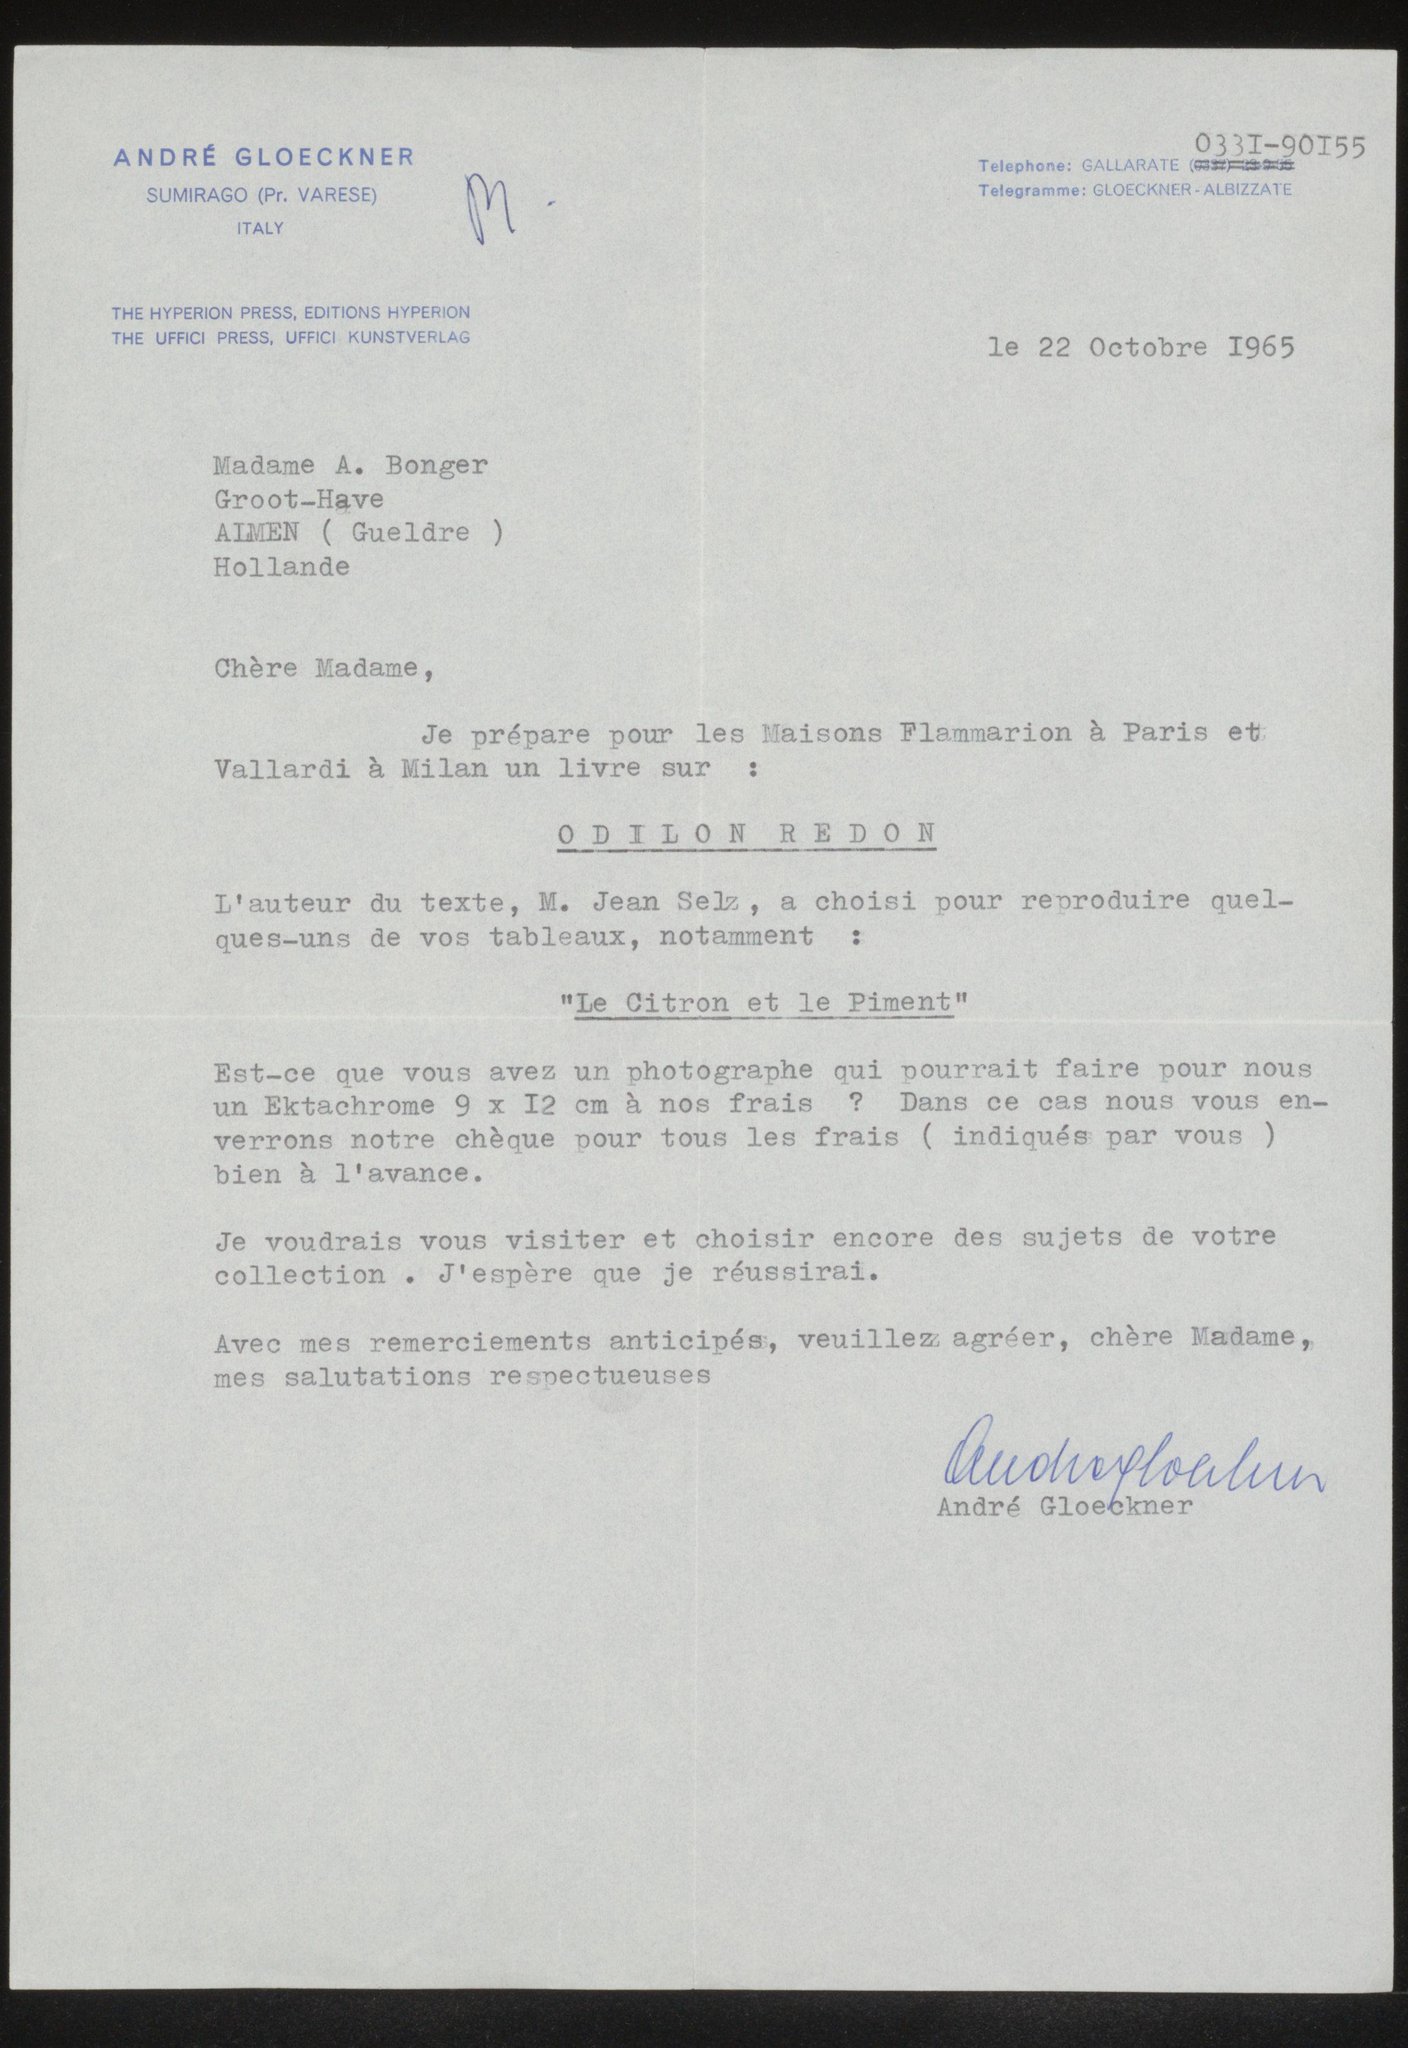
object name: letter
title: Brief aan Françoise W.M. Bonger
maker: andré gloeckner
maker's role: auteur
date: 1965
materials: ink, paper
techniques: pen, typewriting, writing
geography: sumirago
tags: jean selz, paris, painter, print maker, draughtsman, odilon redon, françoise w.m. bonger, photography, cinematography, painting (including book-illumination, miniature-painting), art collecting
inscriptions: watermark